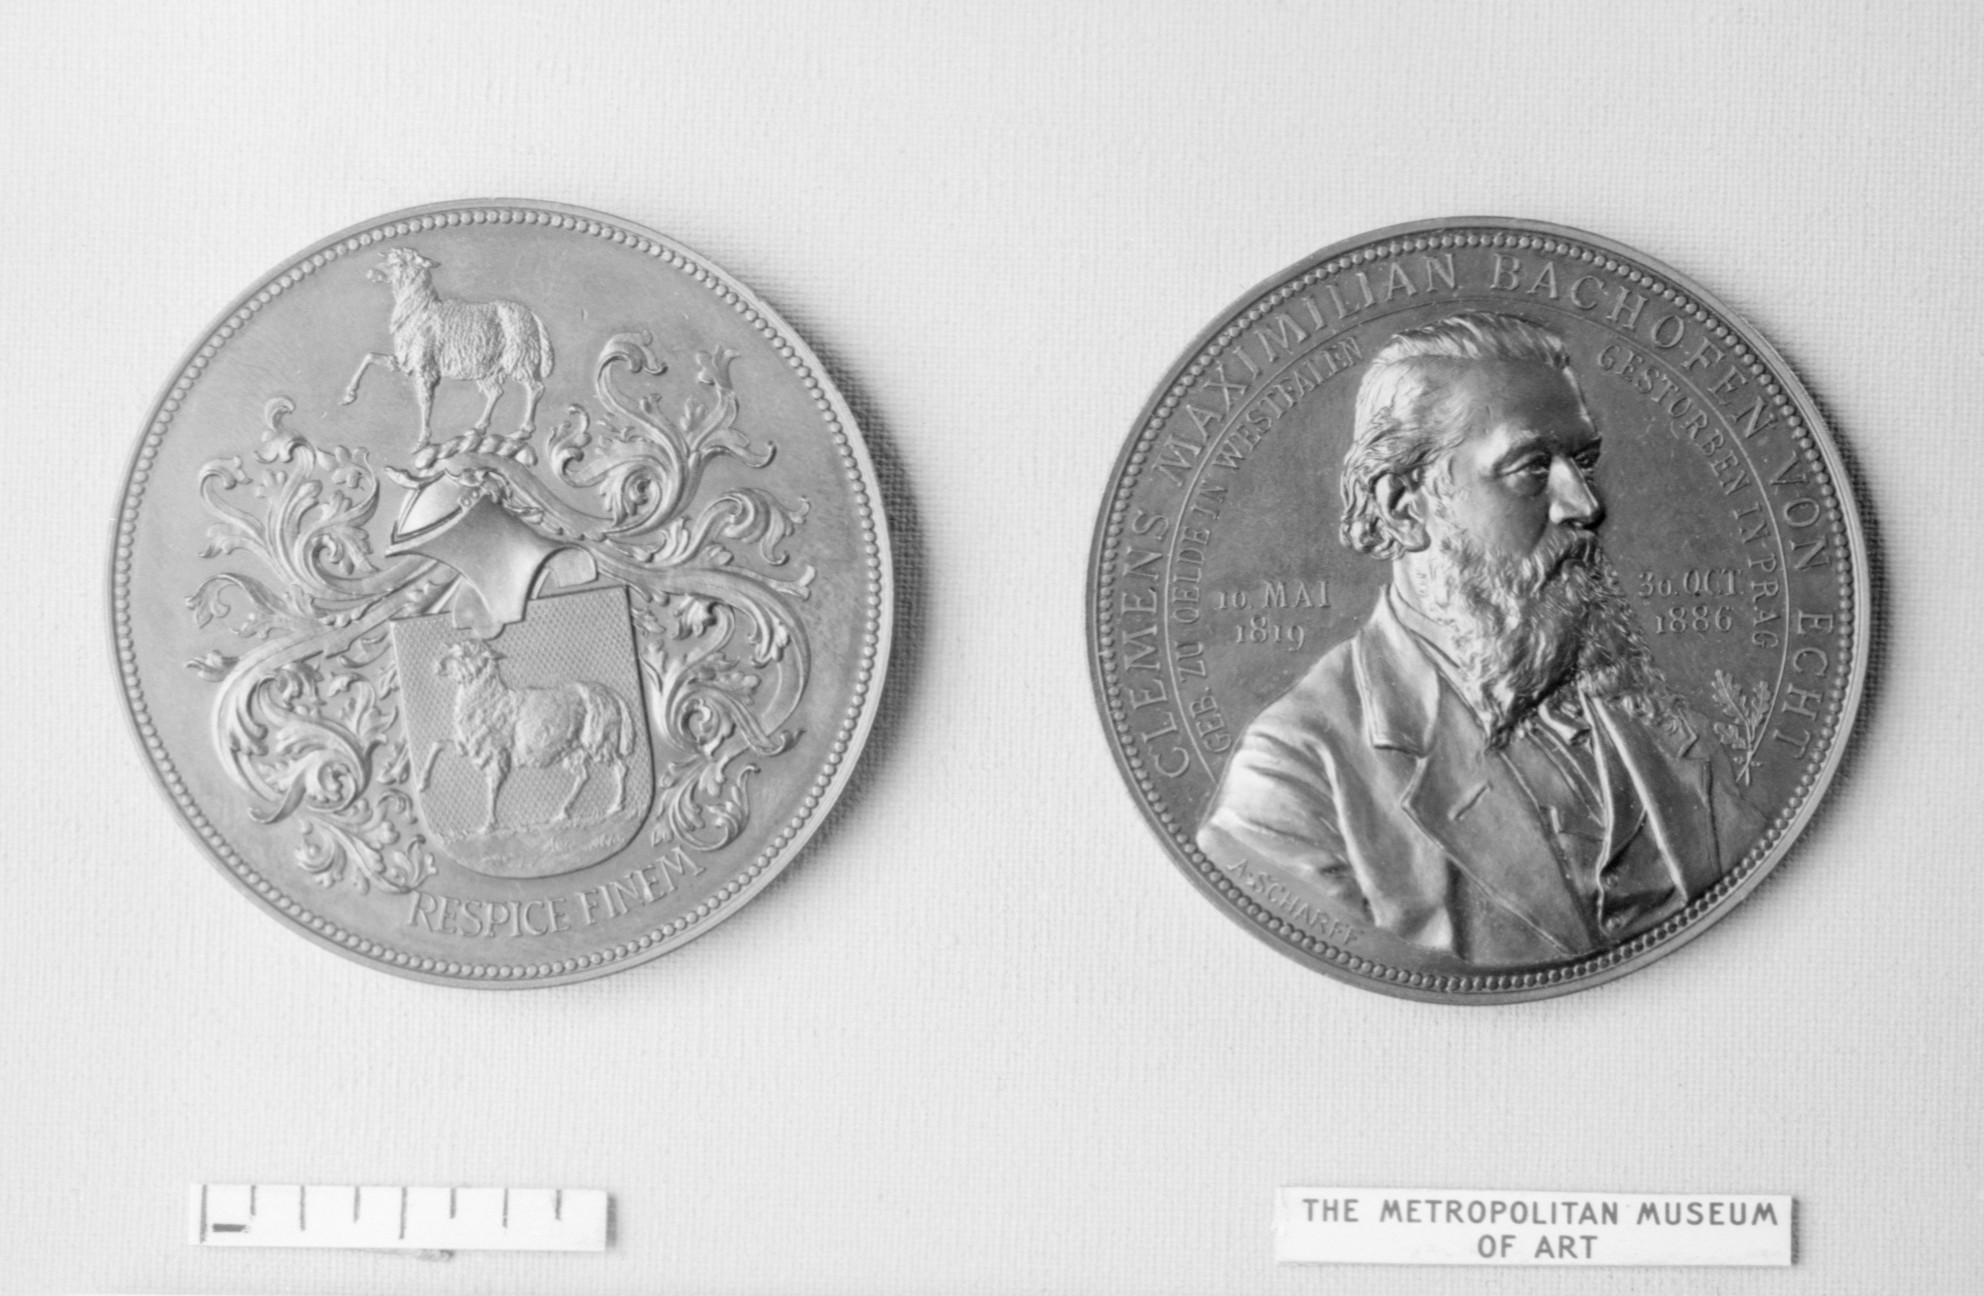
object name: medal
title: Portrait Memorial of C.M. Bachofen von Echt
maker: anton scharff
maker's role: artist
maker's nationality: austrian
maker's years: 1845-1903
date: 1886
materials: bronze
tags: men,portraits,lambs,coat of arms